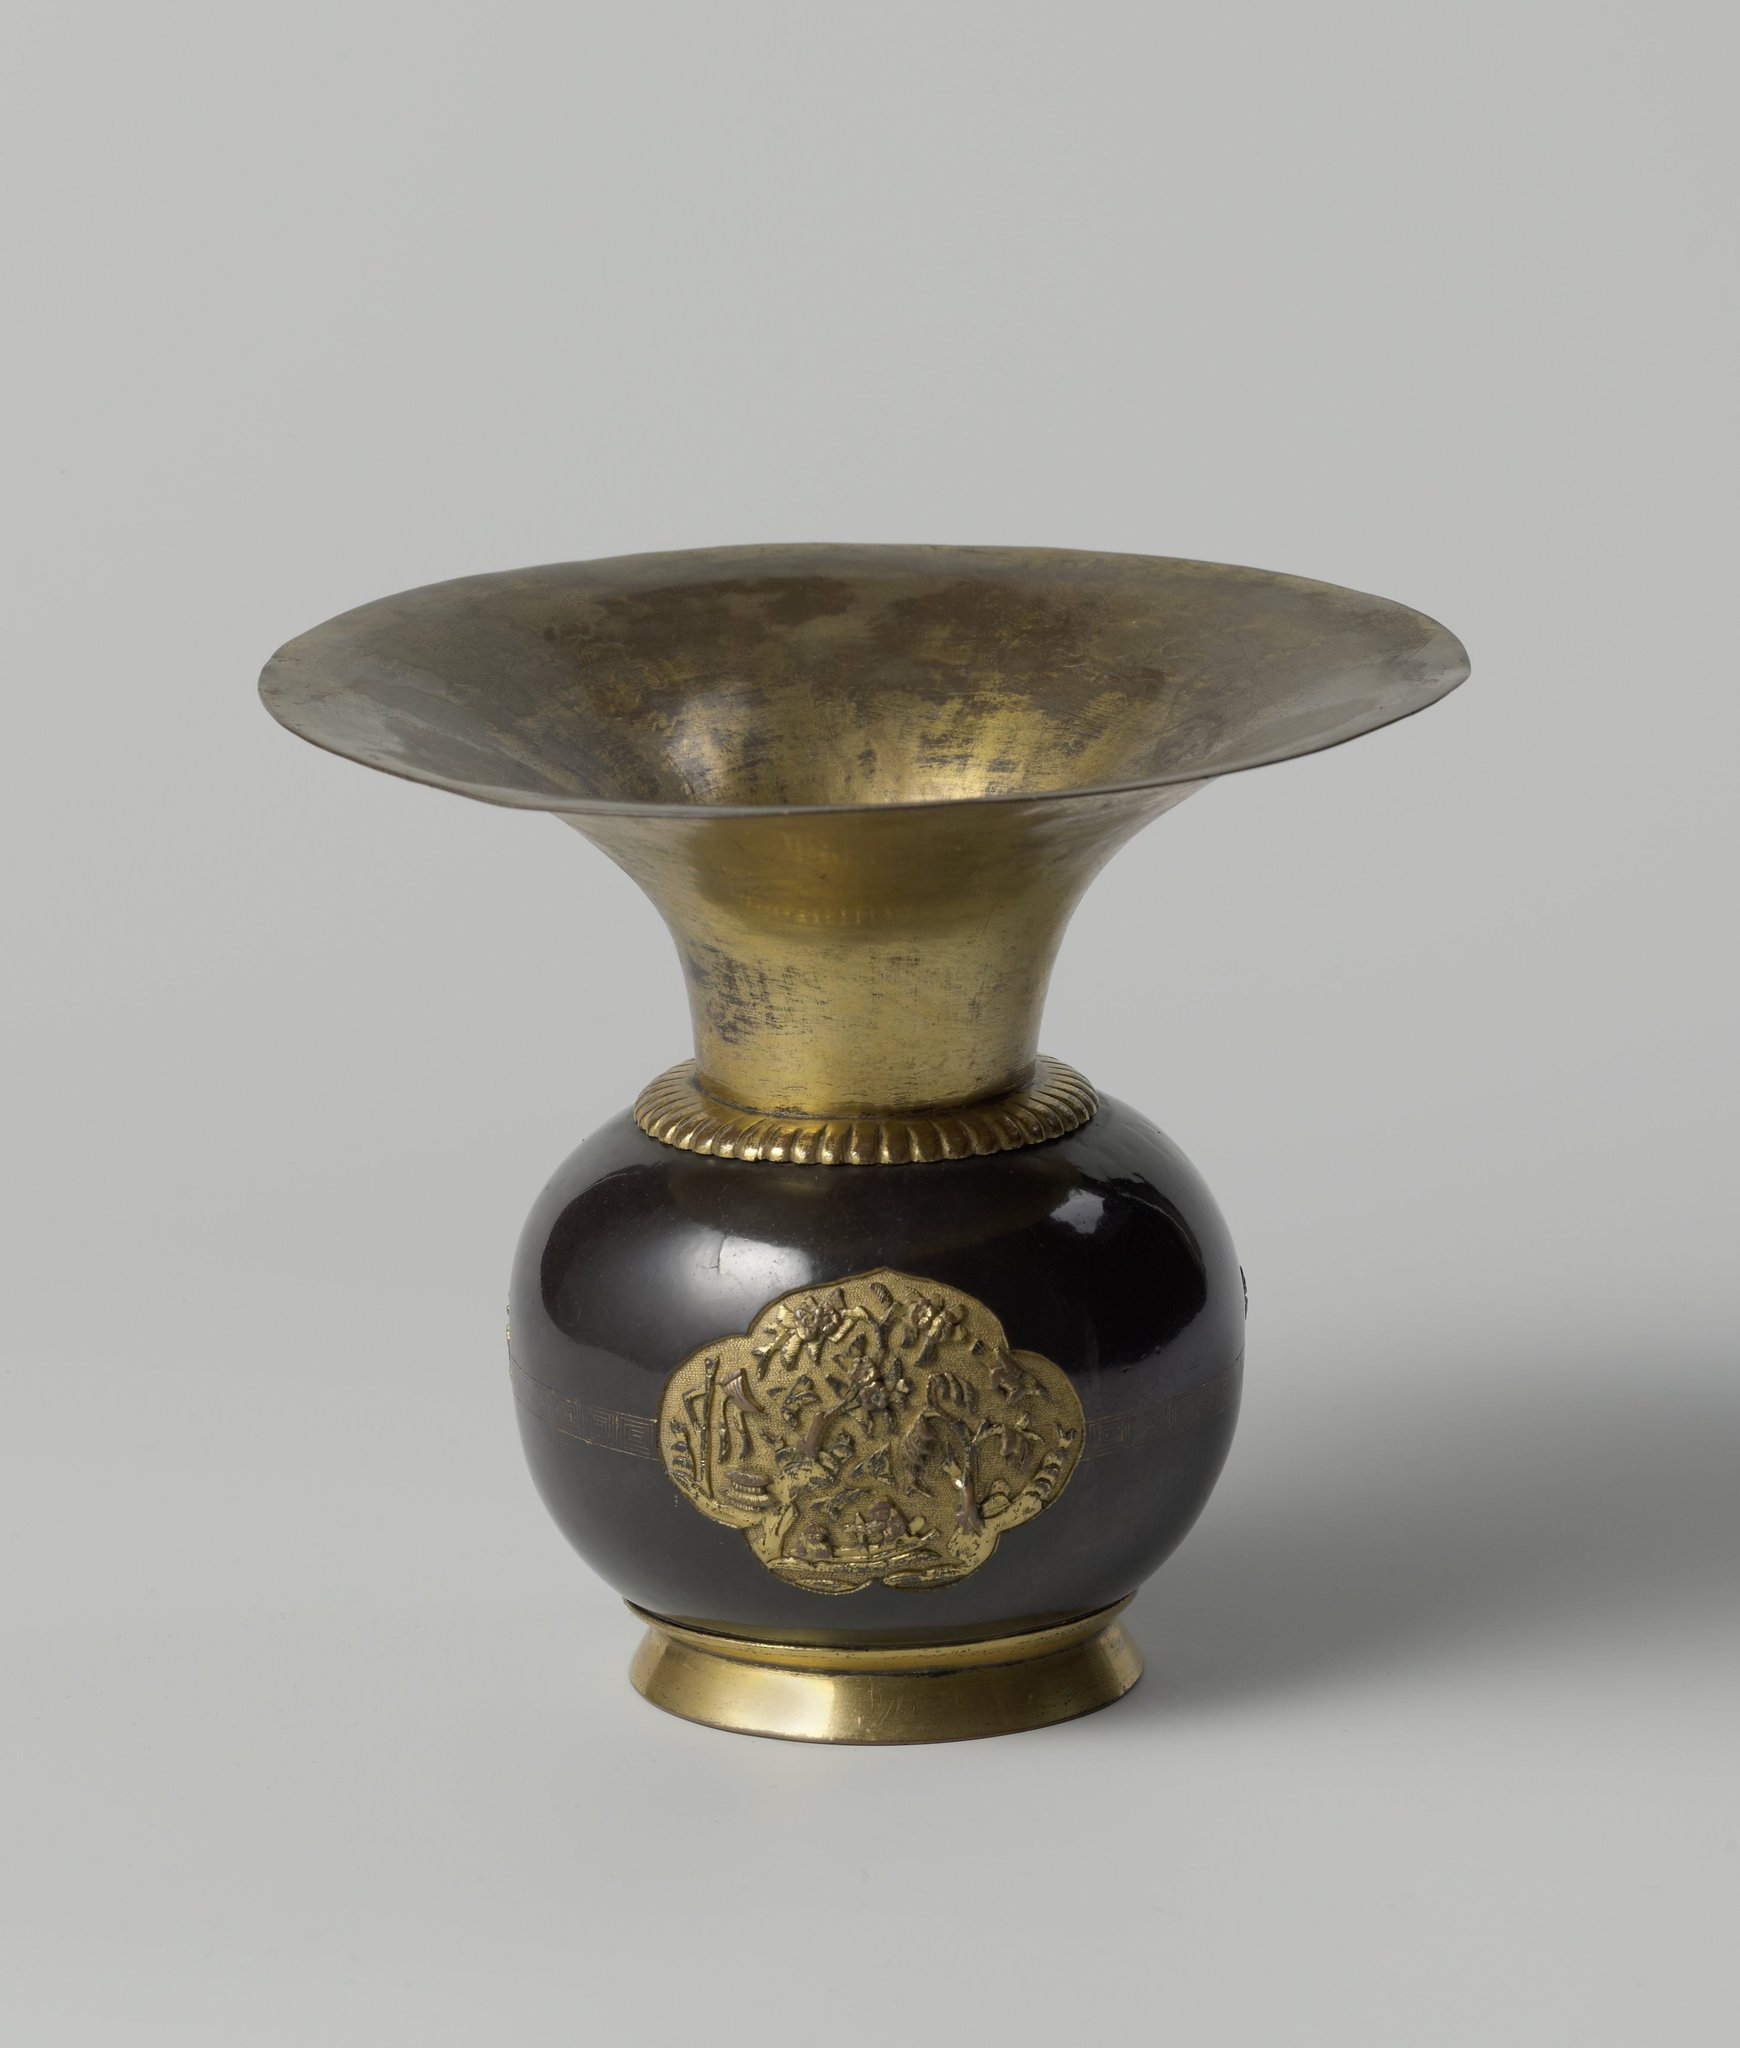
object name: spittoon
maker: Anonymous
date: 1700-1800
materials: metal alloy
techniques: amalgam gilded, casting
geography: tonkin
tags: verenigde oostindische compagnie, vietnam, kanton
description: Kwispedoor met vergulde voet en een trompetvormige mond en een zwart gelakte bolle buik versierd met drie cartouches in relief, voorstellende pagodes en een figuur in een boot temidden van een traditioneel Chinees landschap met bomen, vogels en een vlinder. De binnenzijde van de mond is gegraveerd met fruit, bloemen en vogels.